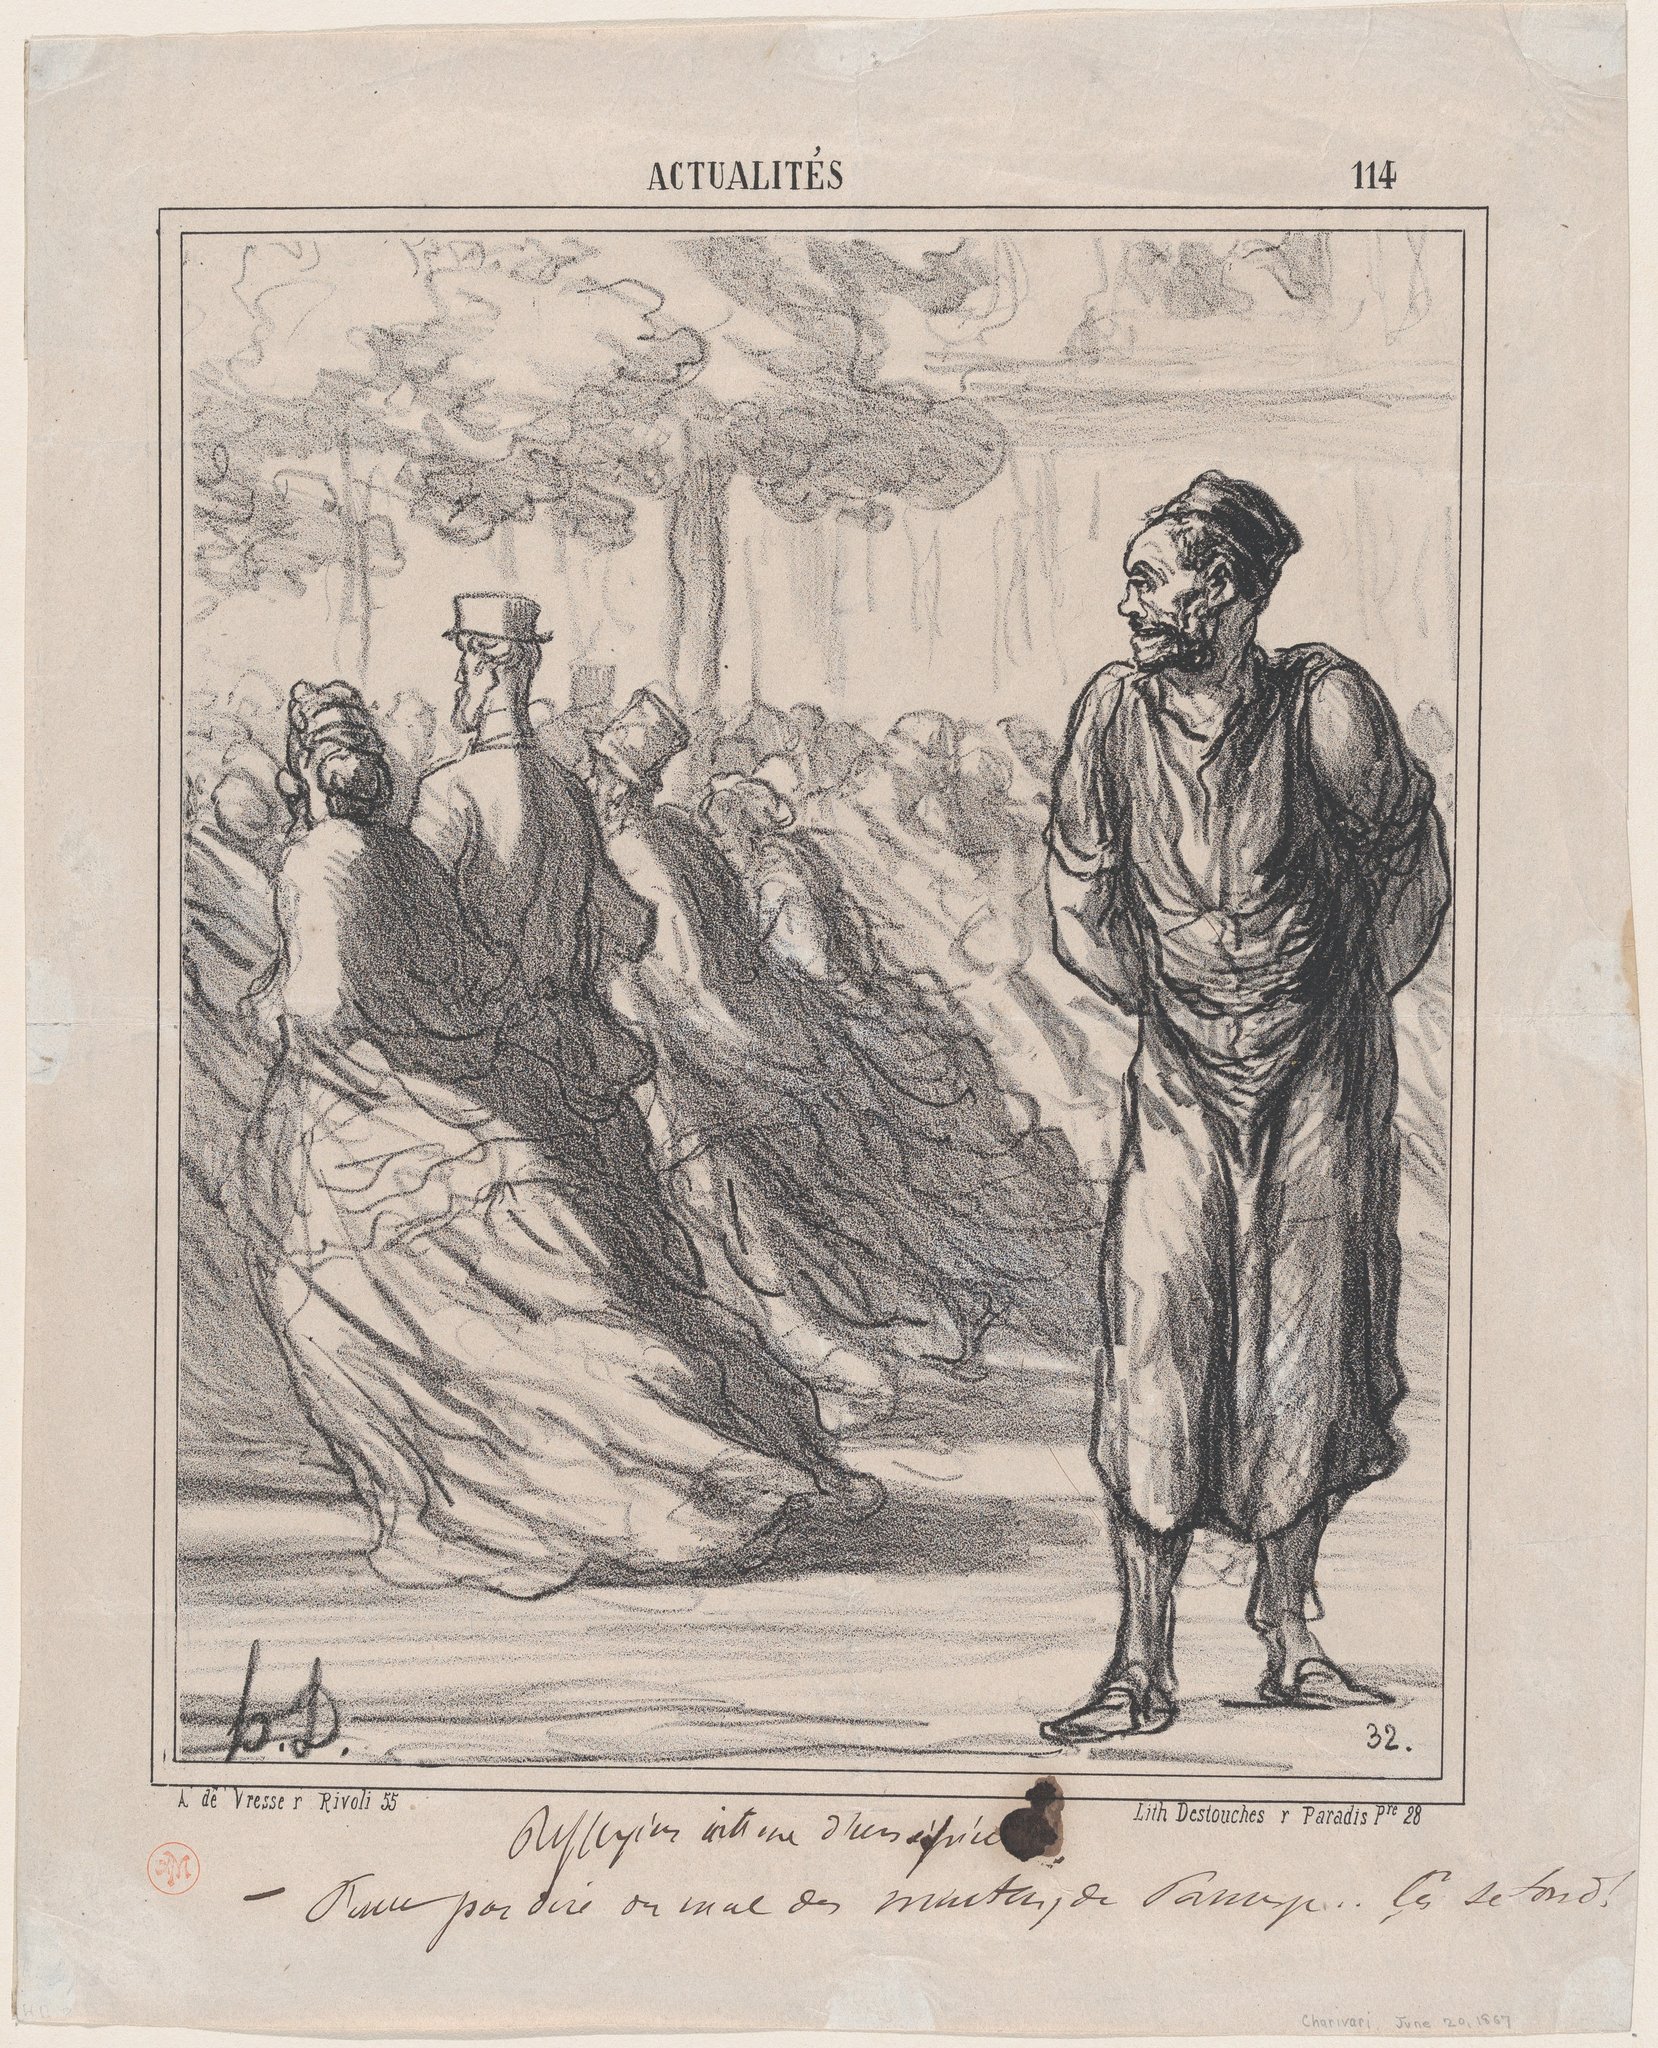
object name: print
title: Deep thoughts of a grocer: One really mustn't speak badly of the sheep of Panurge... these here are getting sheared too, from 'News of the day,' published in "Le Charivari"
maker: honoré daumier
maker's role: artist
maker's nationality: french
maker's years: 1808-1879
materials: ink, paper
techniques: lithograph, pen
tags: satire,men